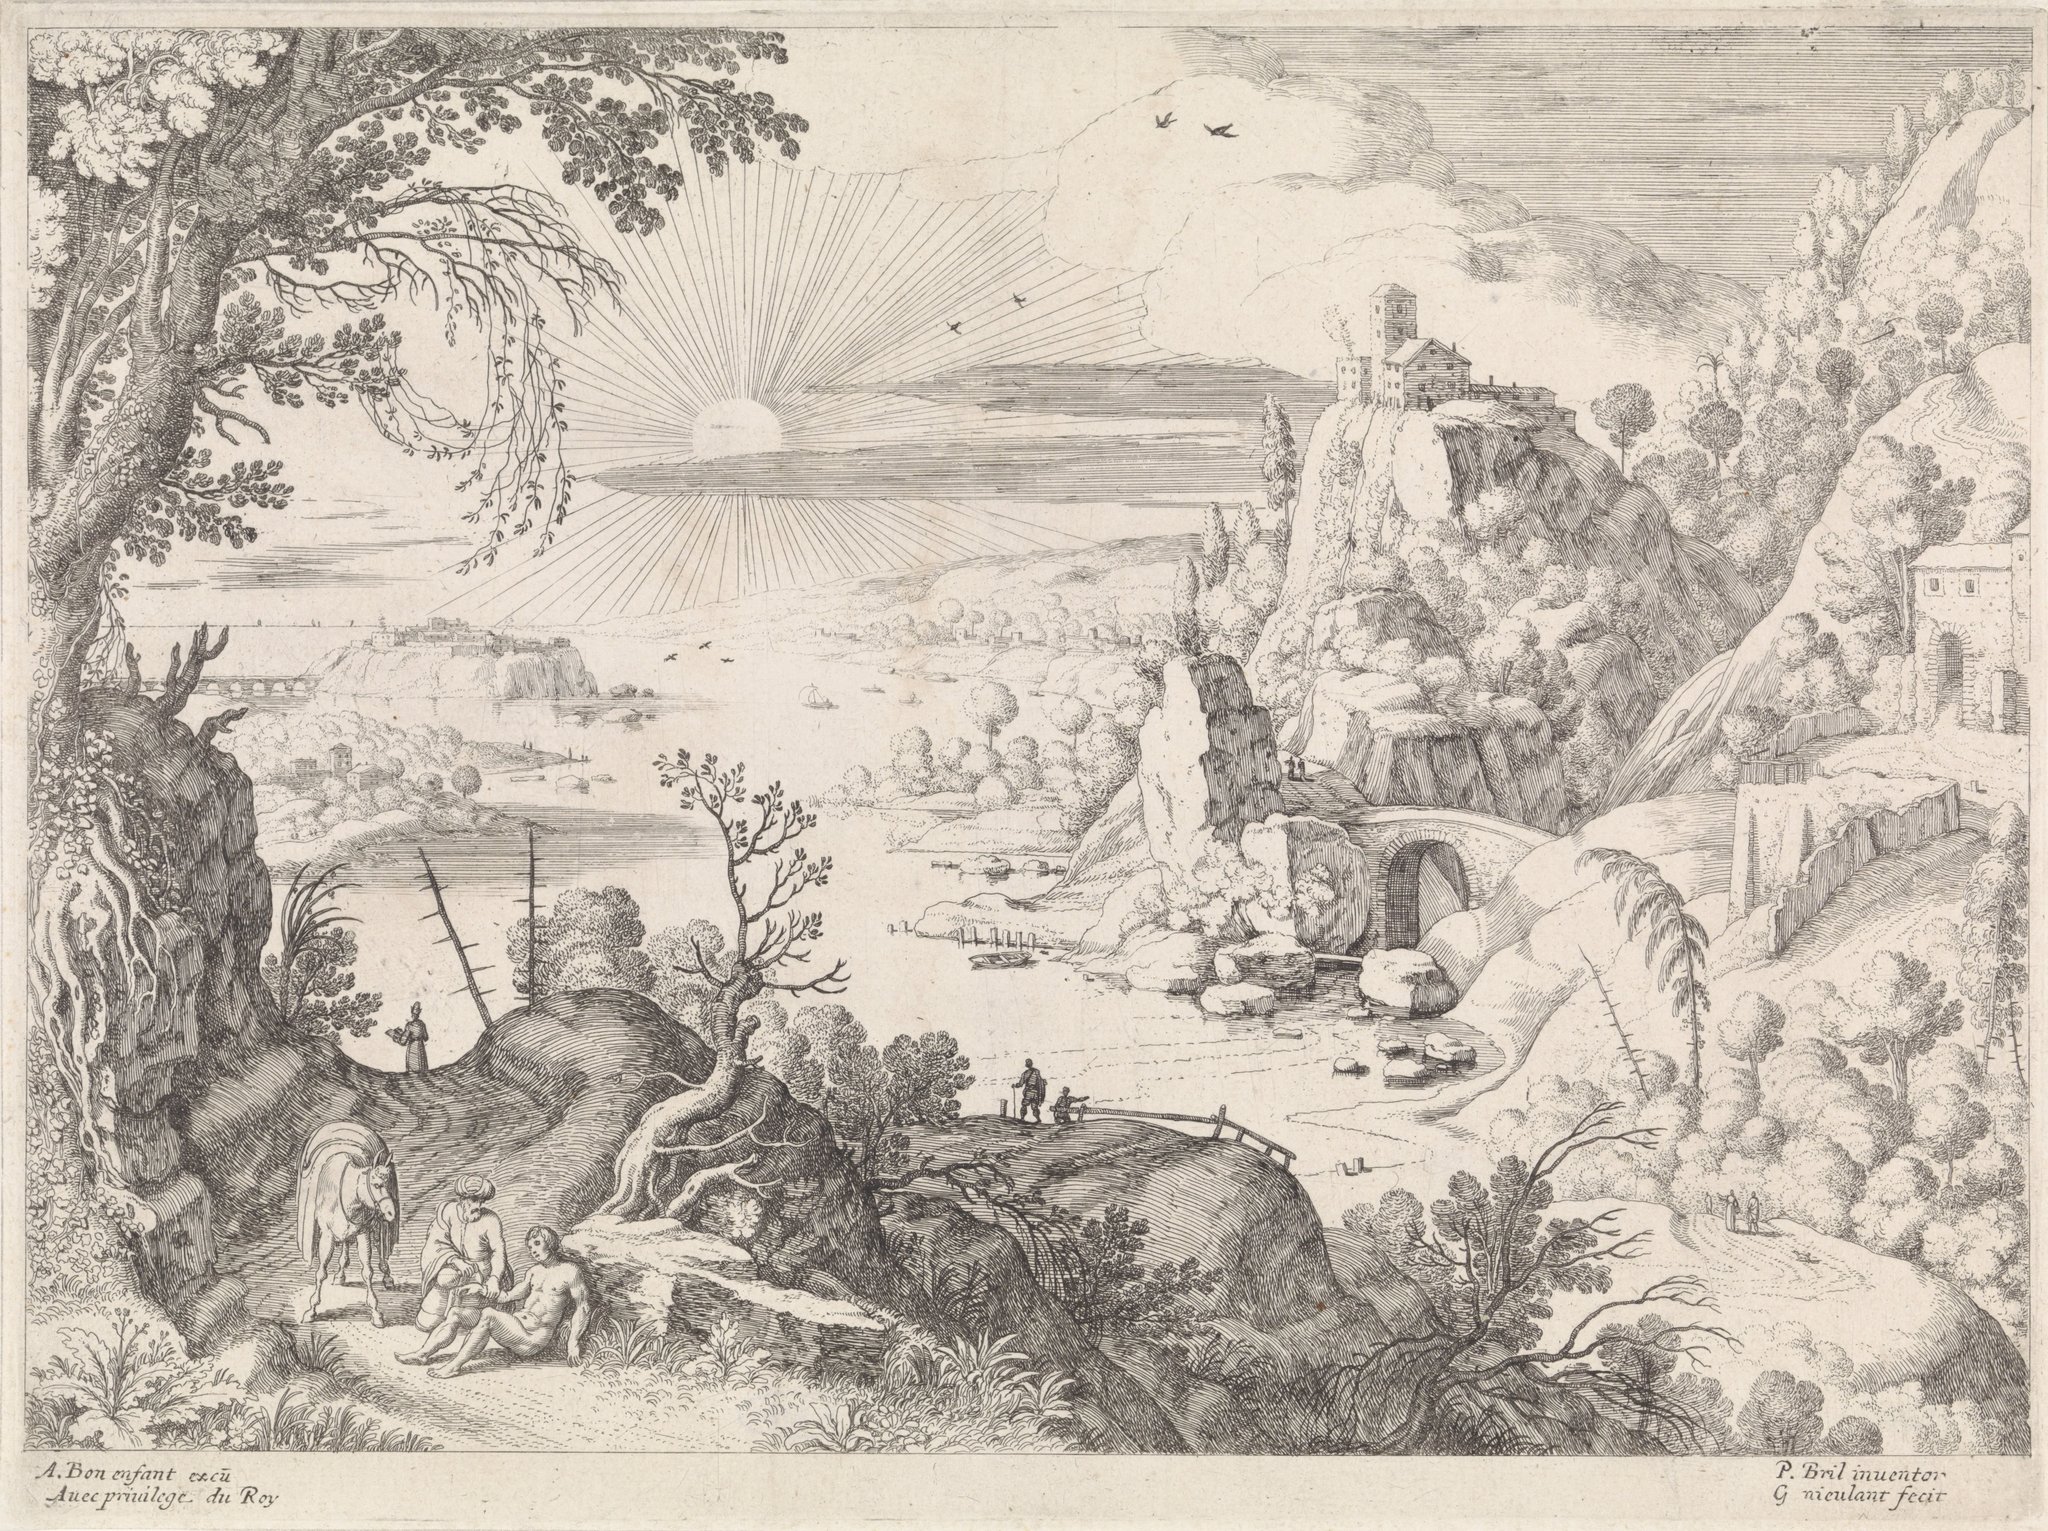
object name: print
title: Landschap met de barmhartige Samaritaan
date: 1594-1635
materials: paper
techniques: engraving, etching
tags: landscapes in the temperate zone, a samaritan tending the wounds of the traveller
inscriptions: collector's mark: Lugt 2228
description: In een Italiaans kustlandschap verzorgt de barmhartige Samaritaan de gewonde reiziger. Naast hen staat de ezel van de Samaritaan. Naar het Bijbelverhaal uit Luc. 10: 25-37.